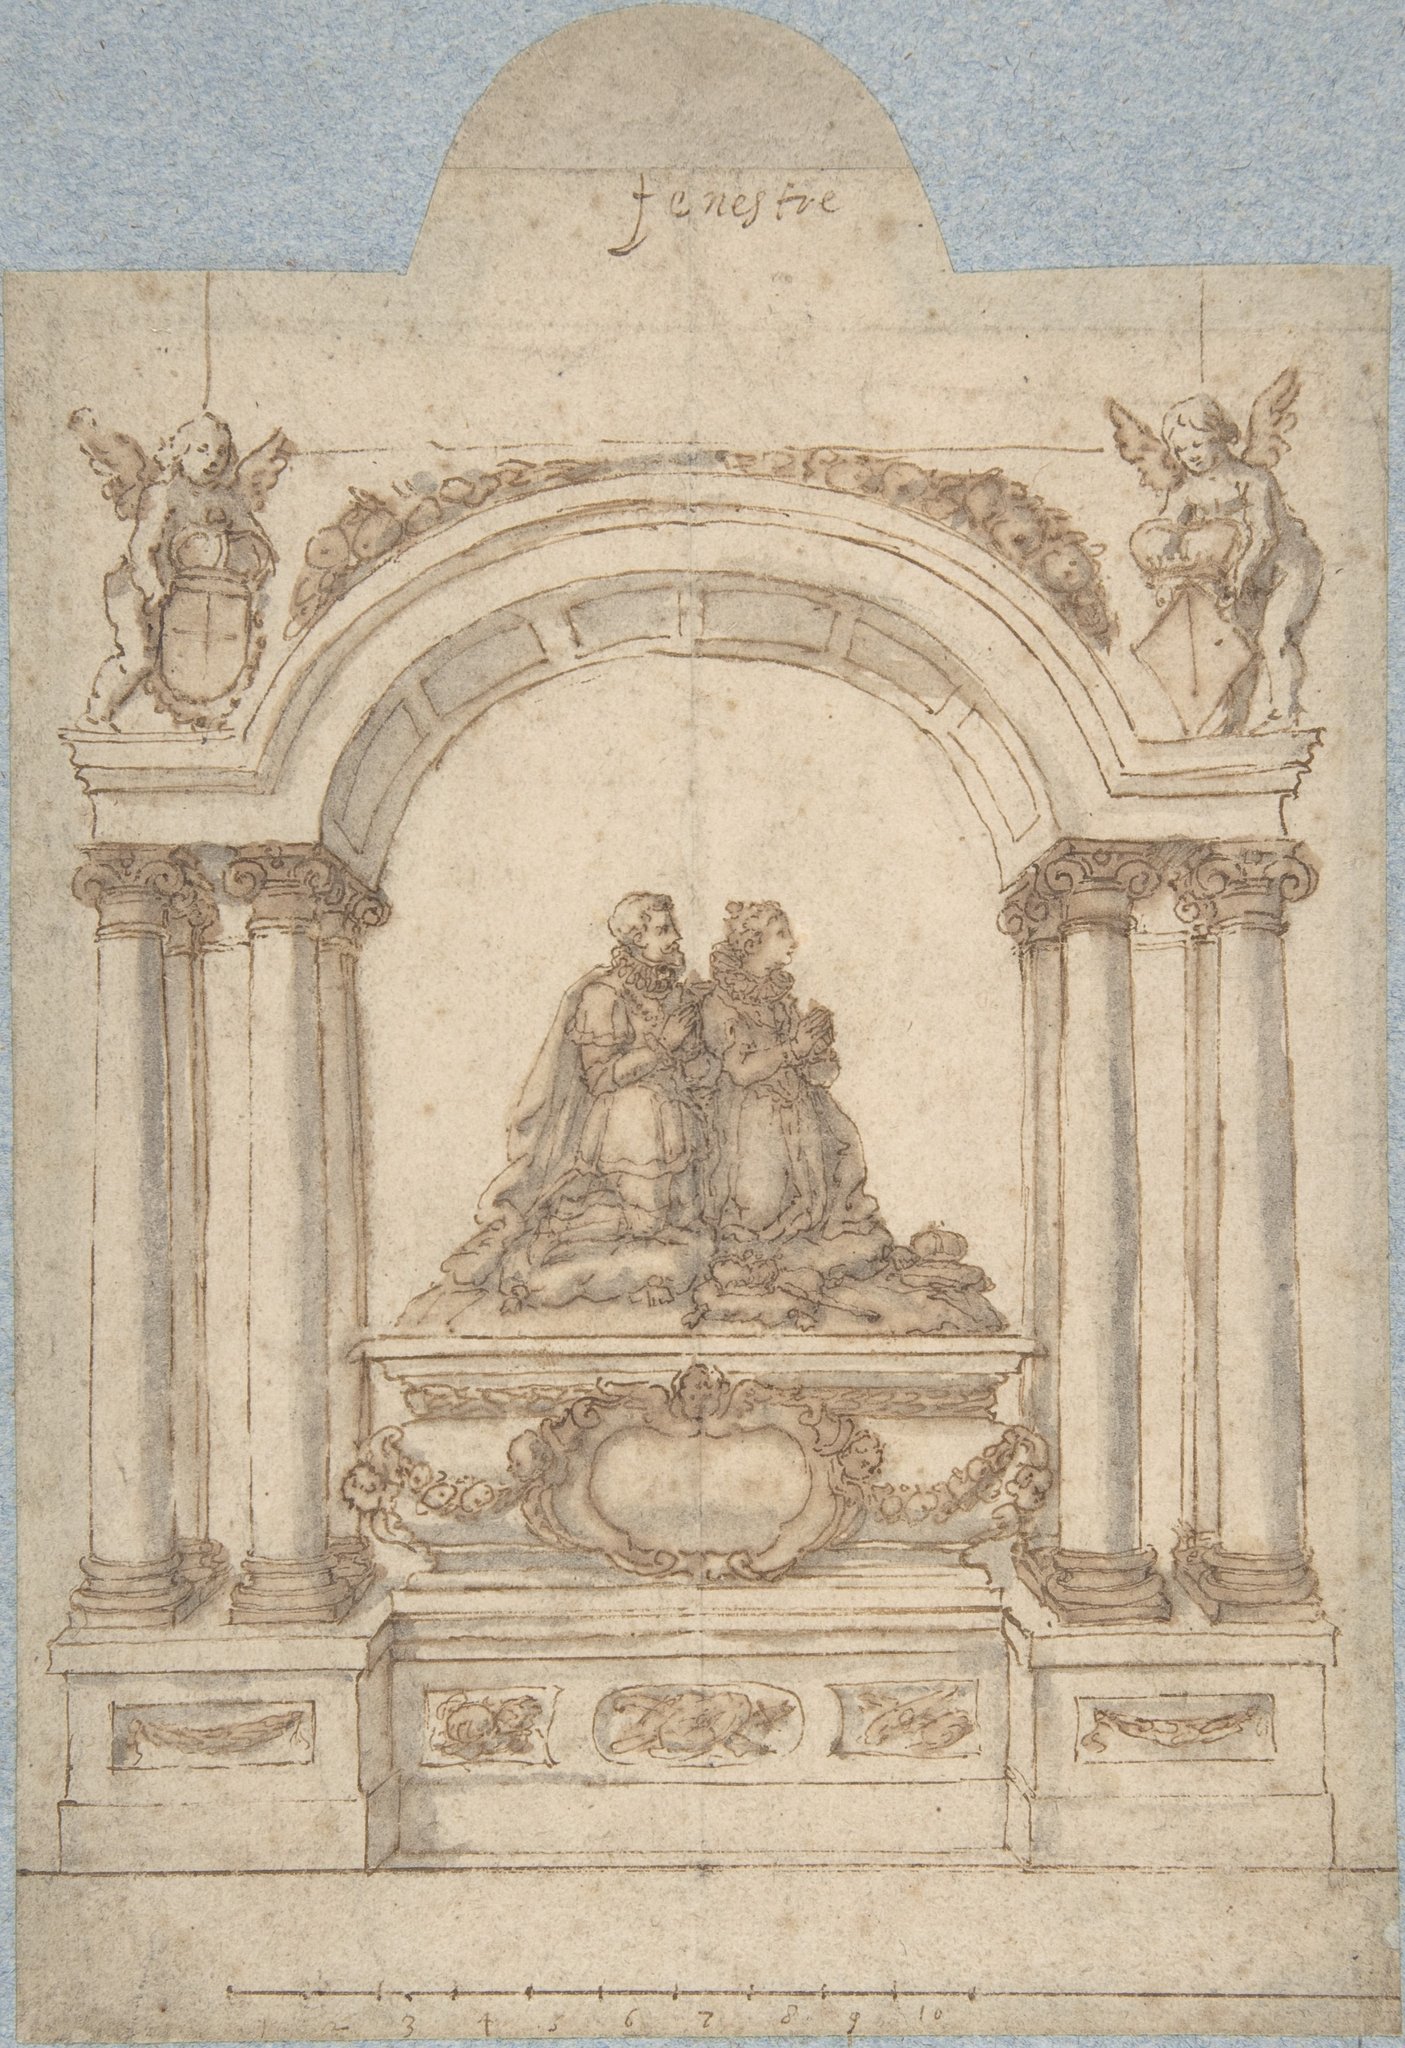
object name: drawing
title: Project for a Tomb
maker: anonymous, french, 16th century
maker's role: artist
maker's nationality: french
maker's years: 1500-1600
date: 1590-1600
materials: ink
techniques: brush, pen, wash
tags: tombs,men,women